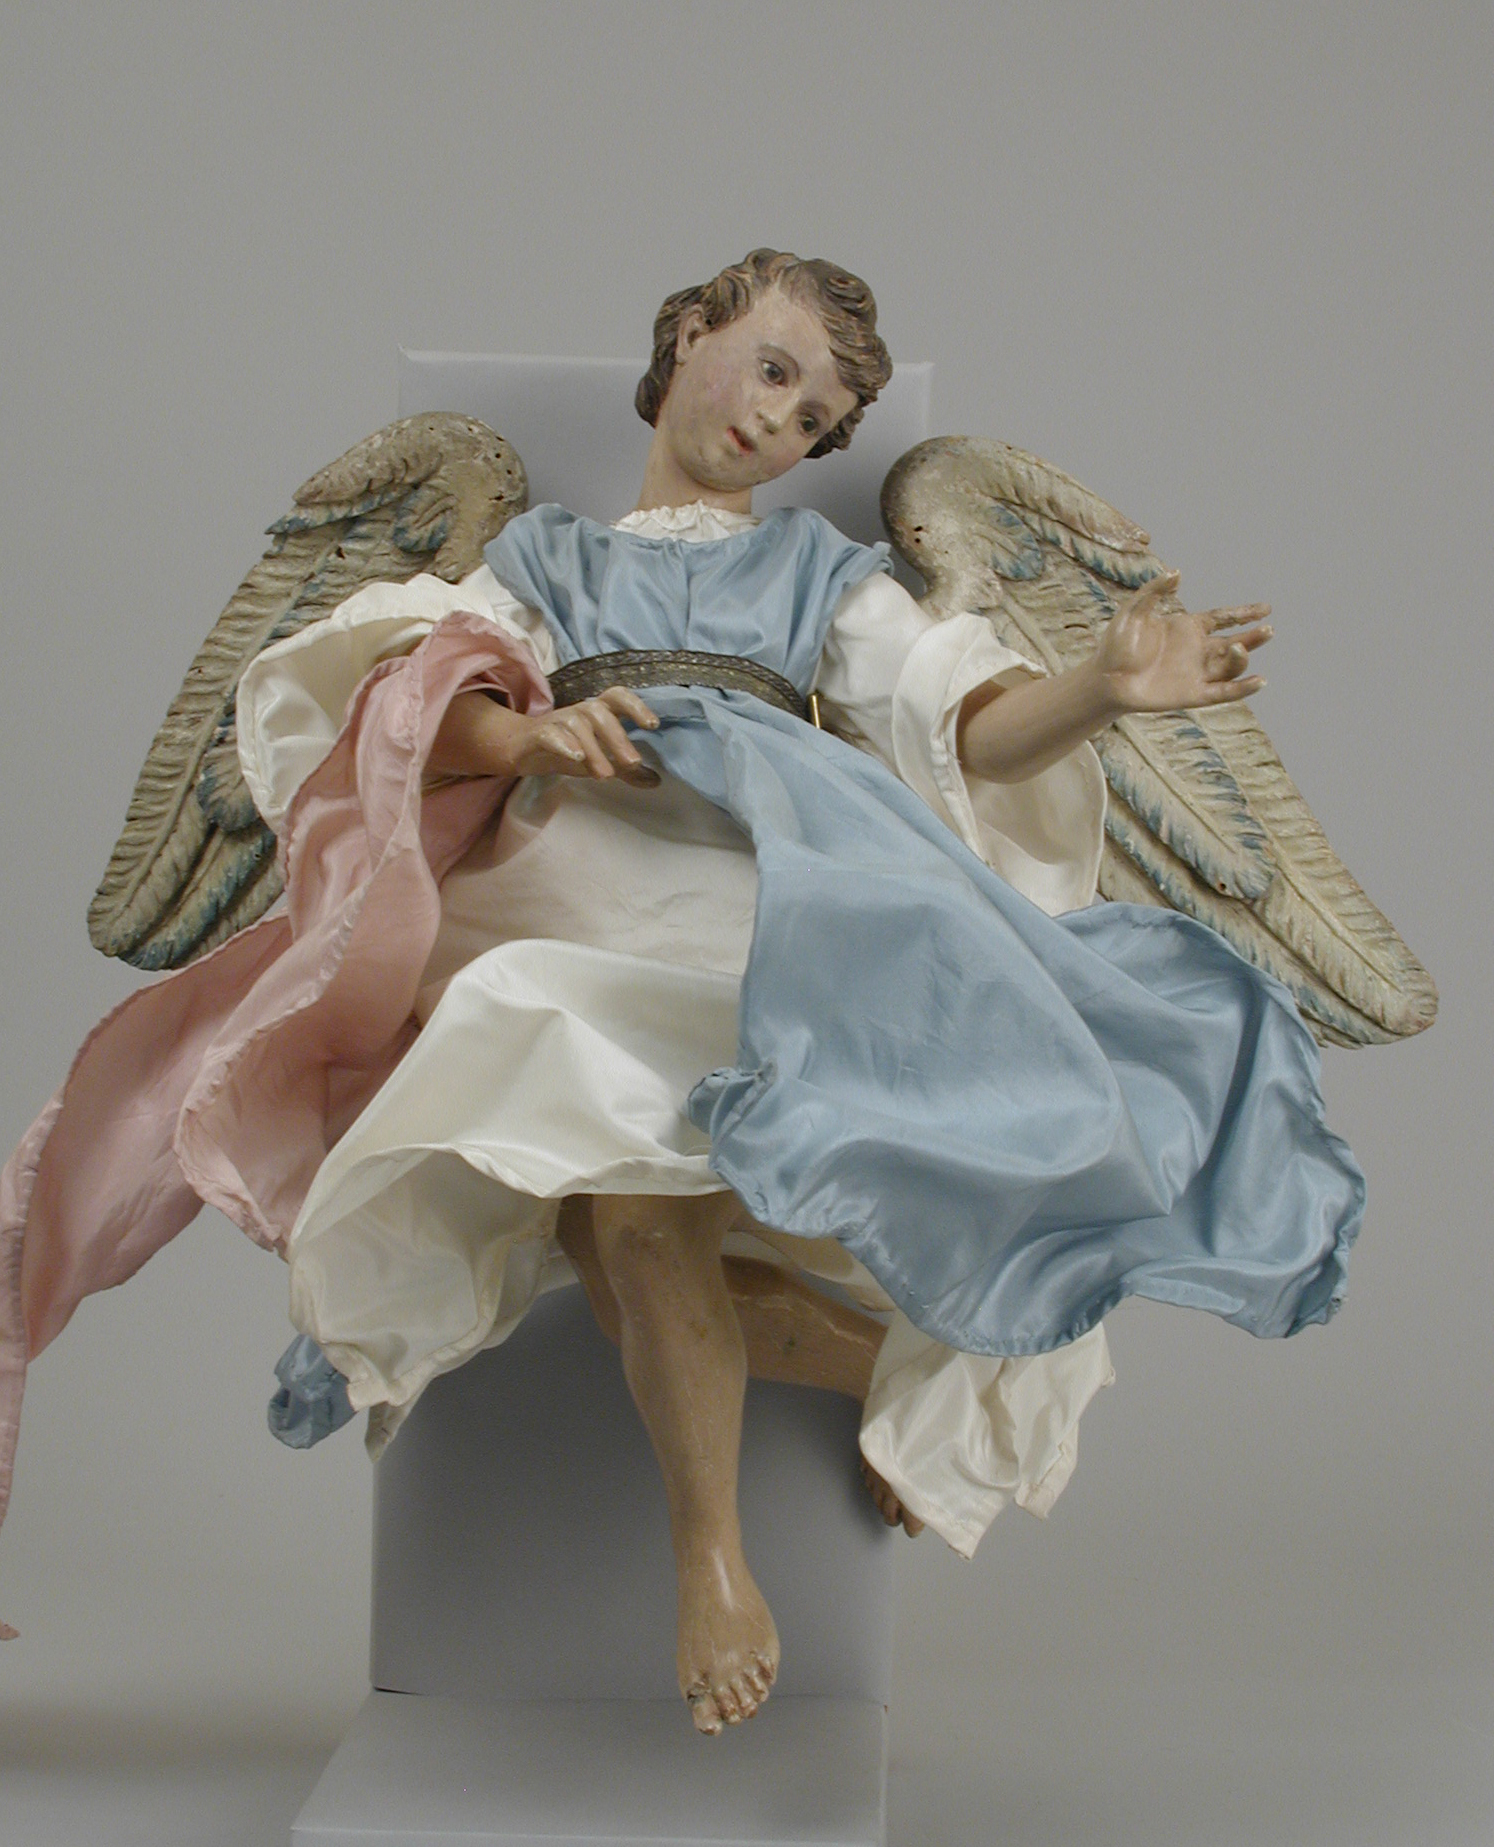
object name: crèche figure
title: Angel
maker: angelo viva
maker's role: maker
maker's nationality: italian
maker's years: 1748-1837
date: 1701-1900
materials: plaster, wood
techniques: polychrome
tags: angels